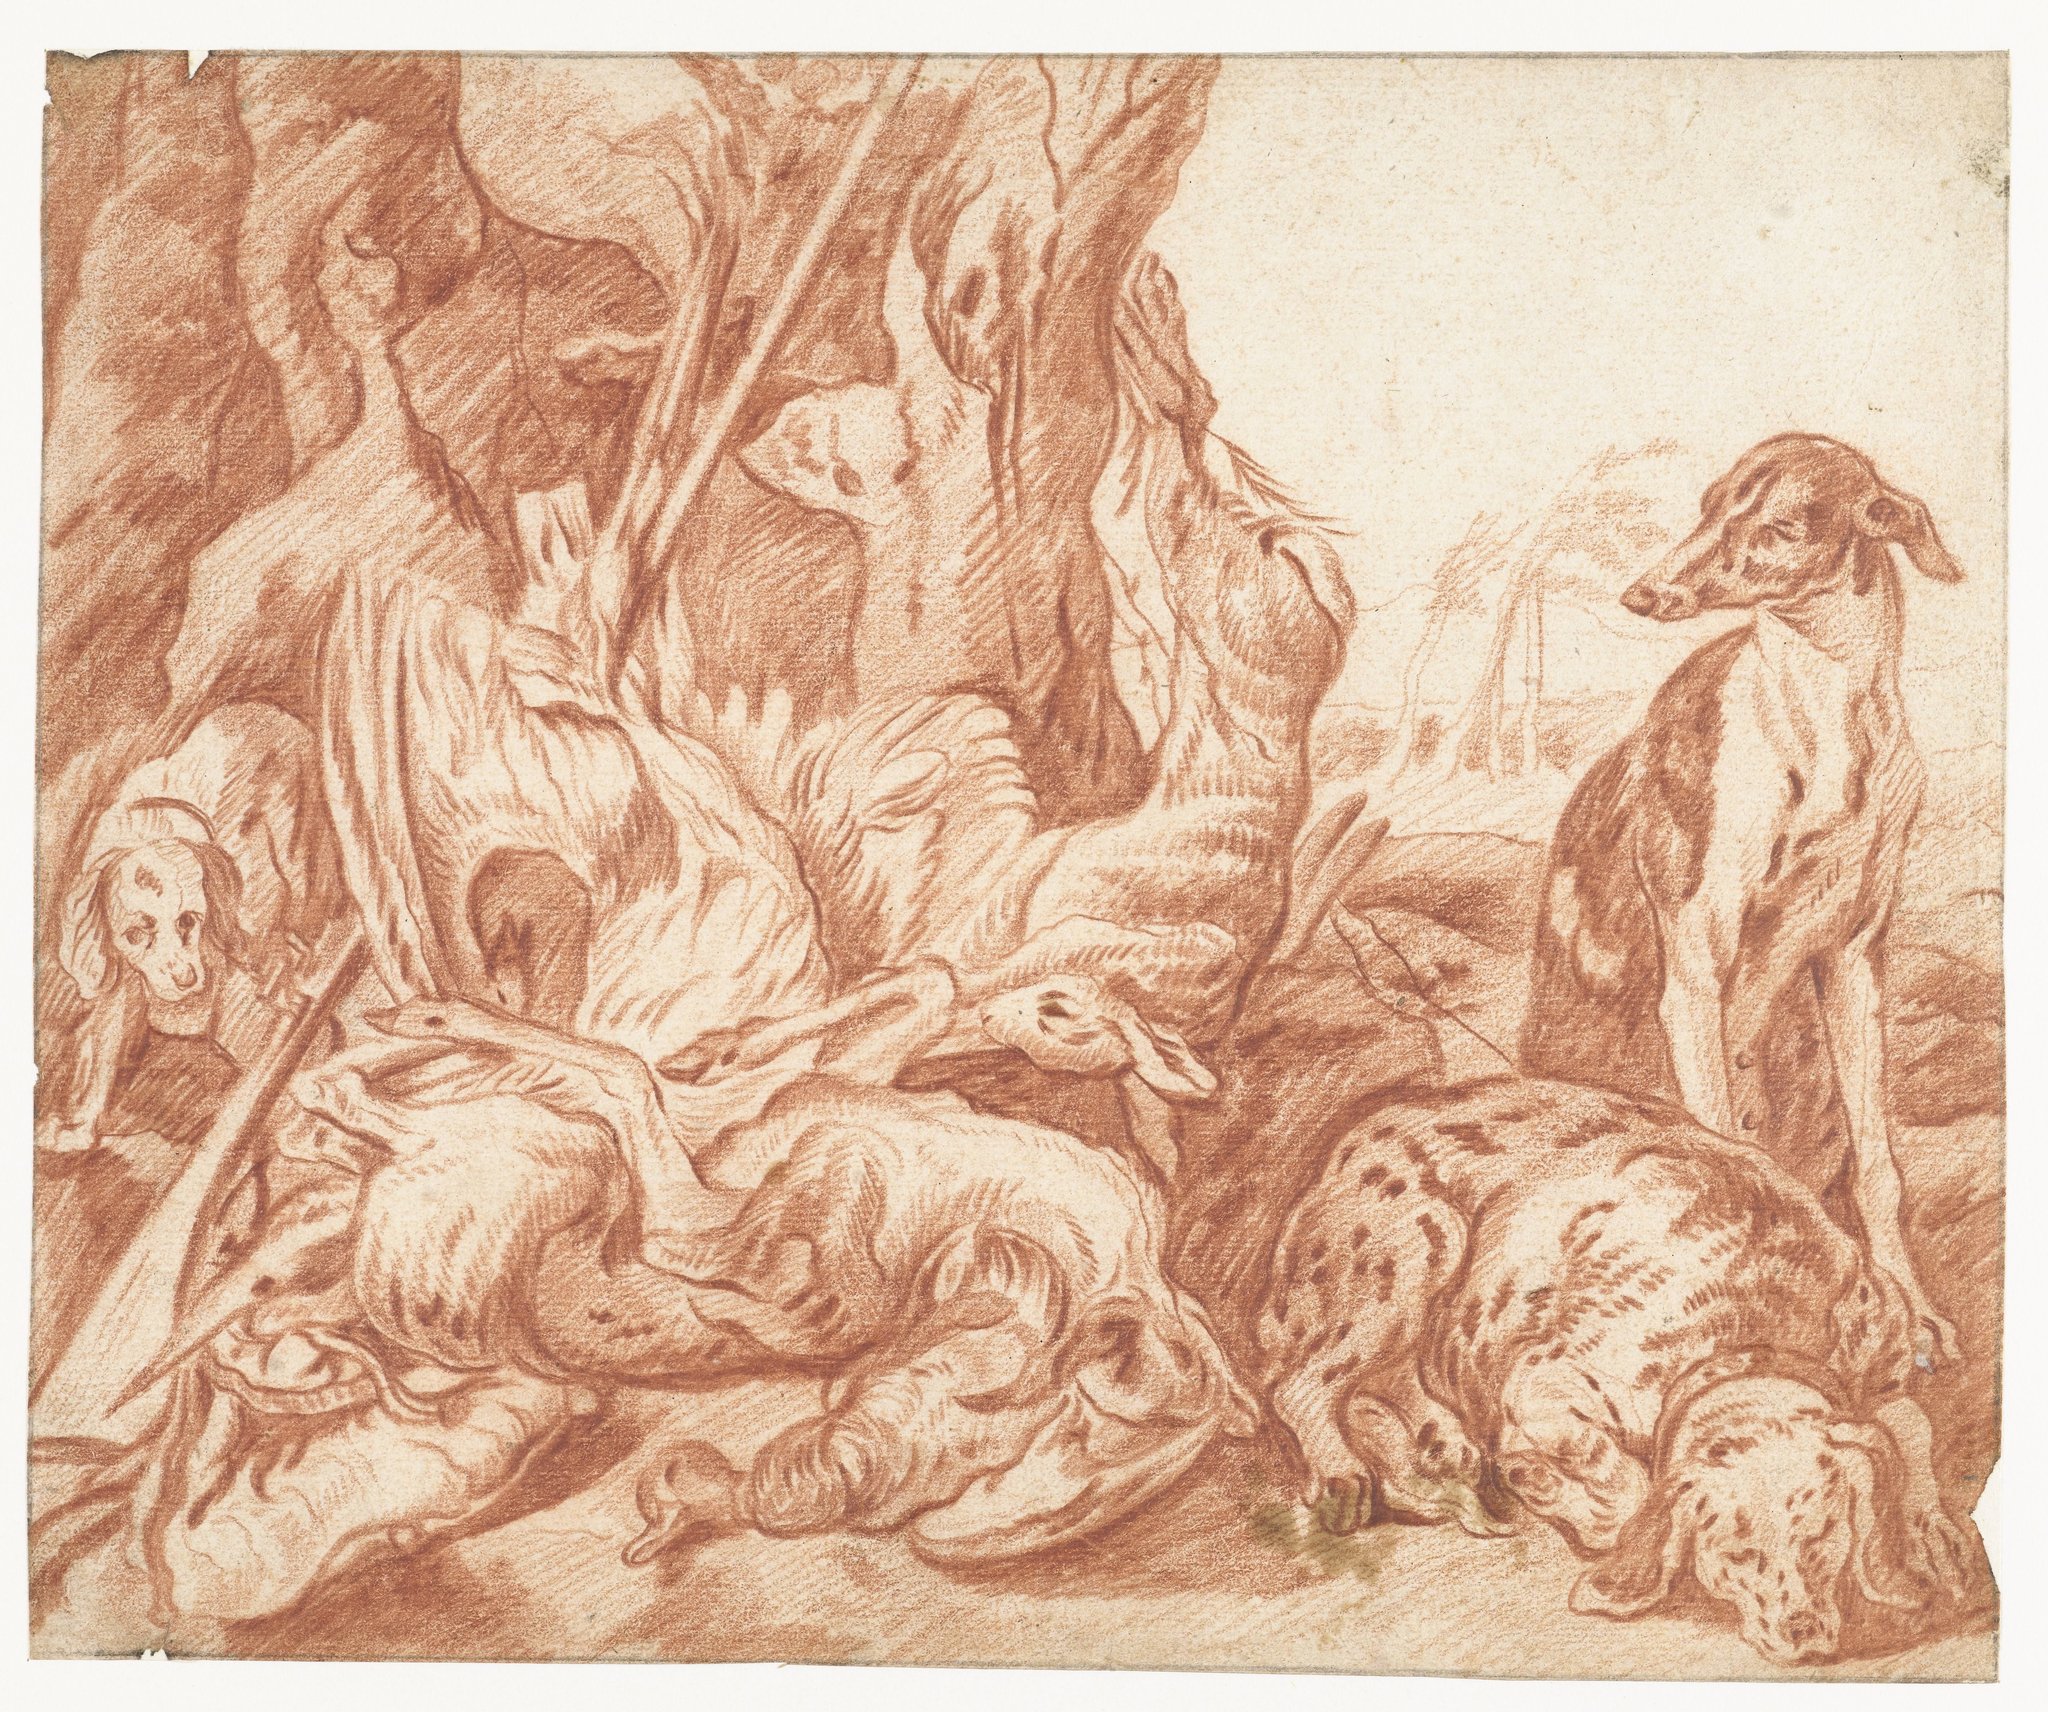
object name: drawing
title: Stilleven van jachtbuit met jachthonden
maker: joannes fijt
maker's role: draughtsman, print maker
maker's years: 1611-1661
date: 1621-1661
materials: chalk, paper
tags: spoils of the hunt, game, venison, hunting dogs beside the spoils